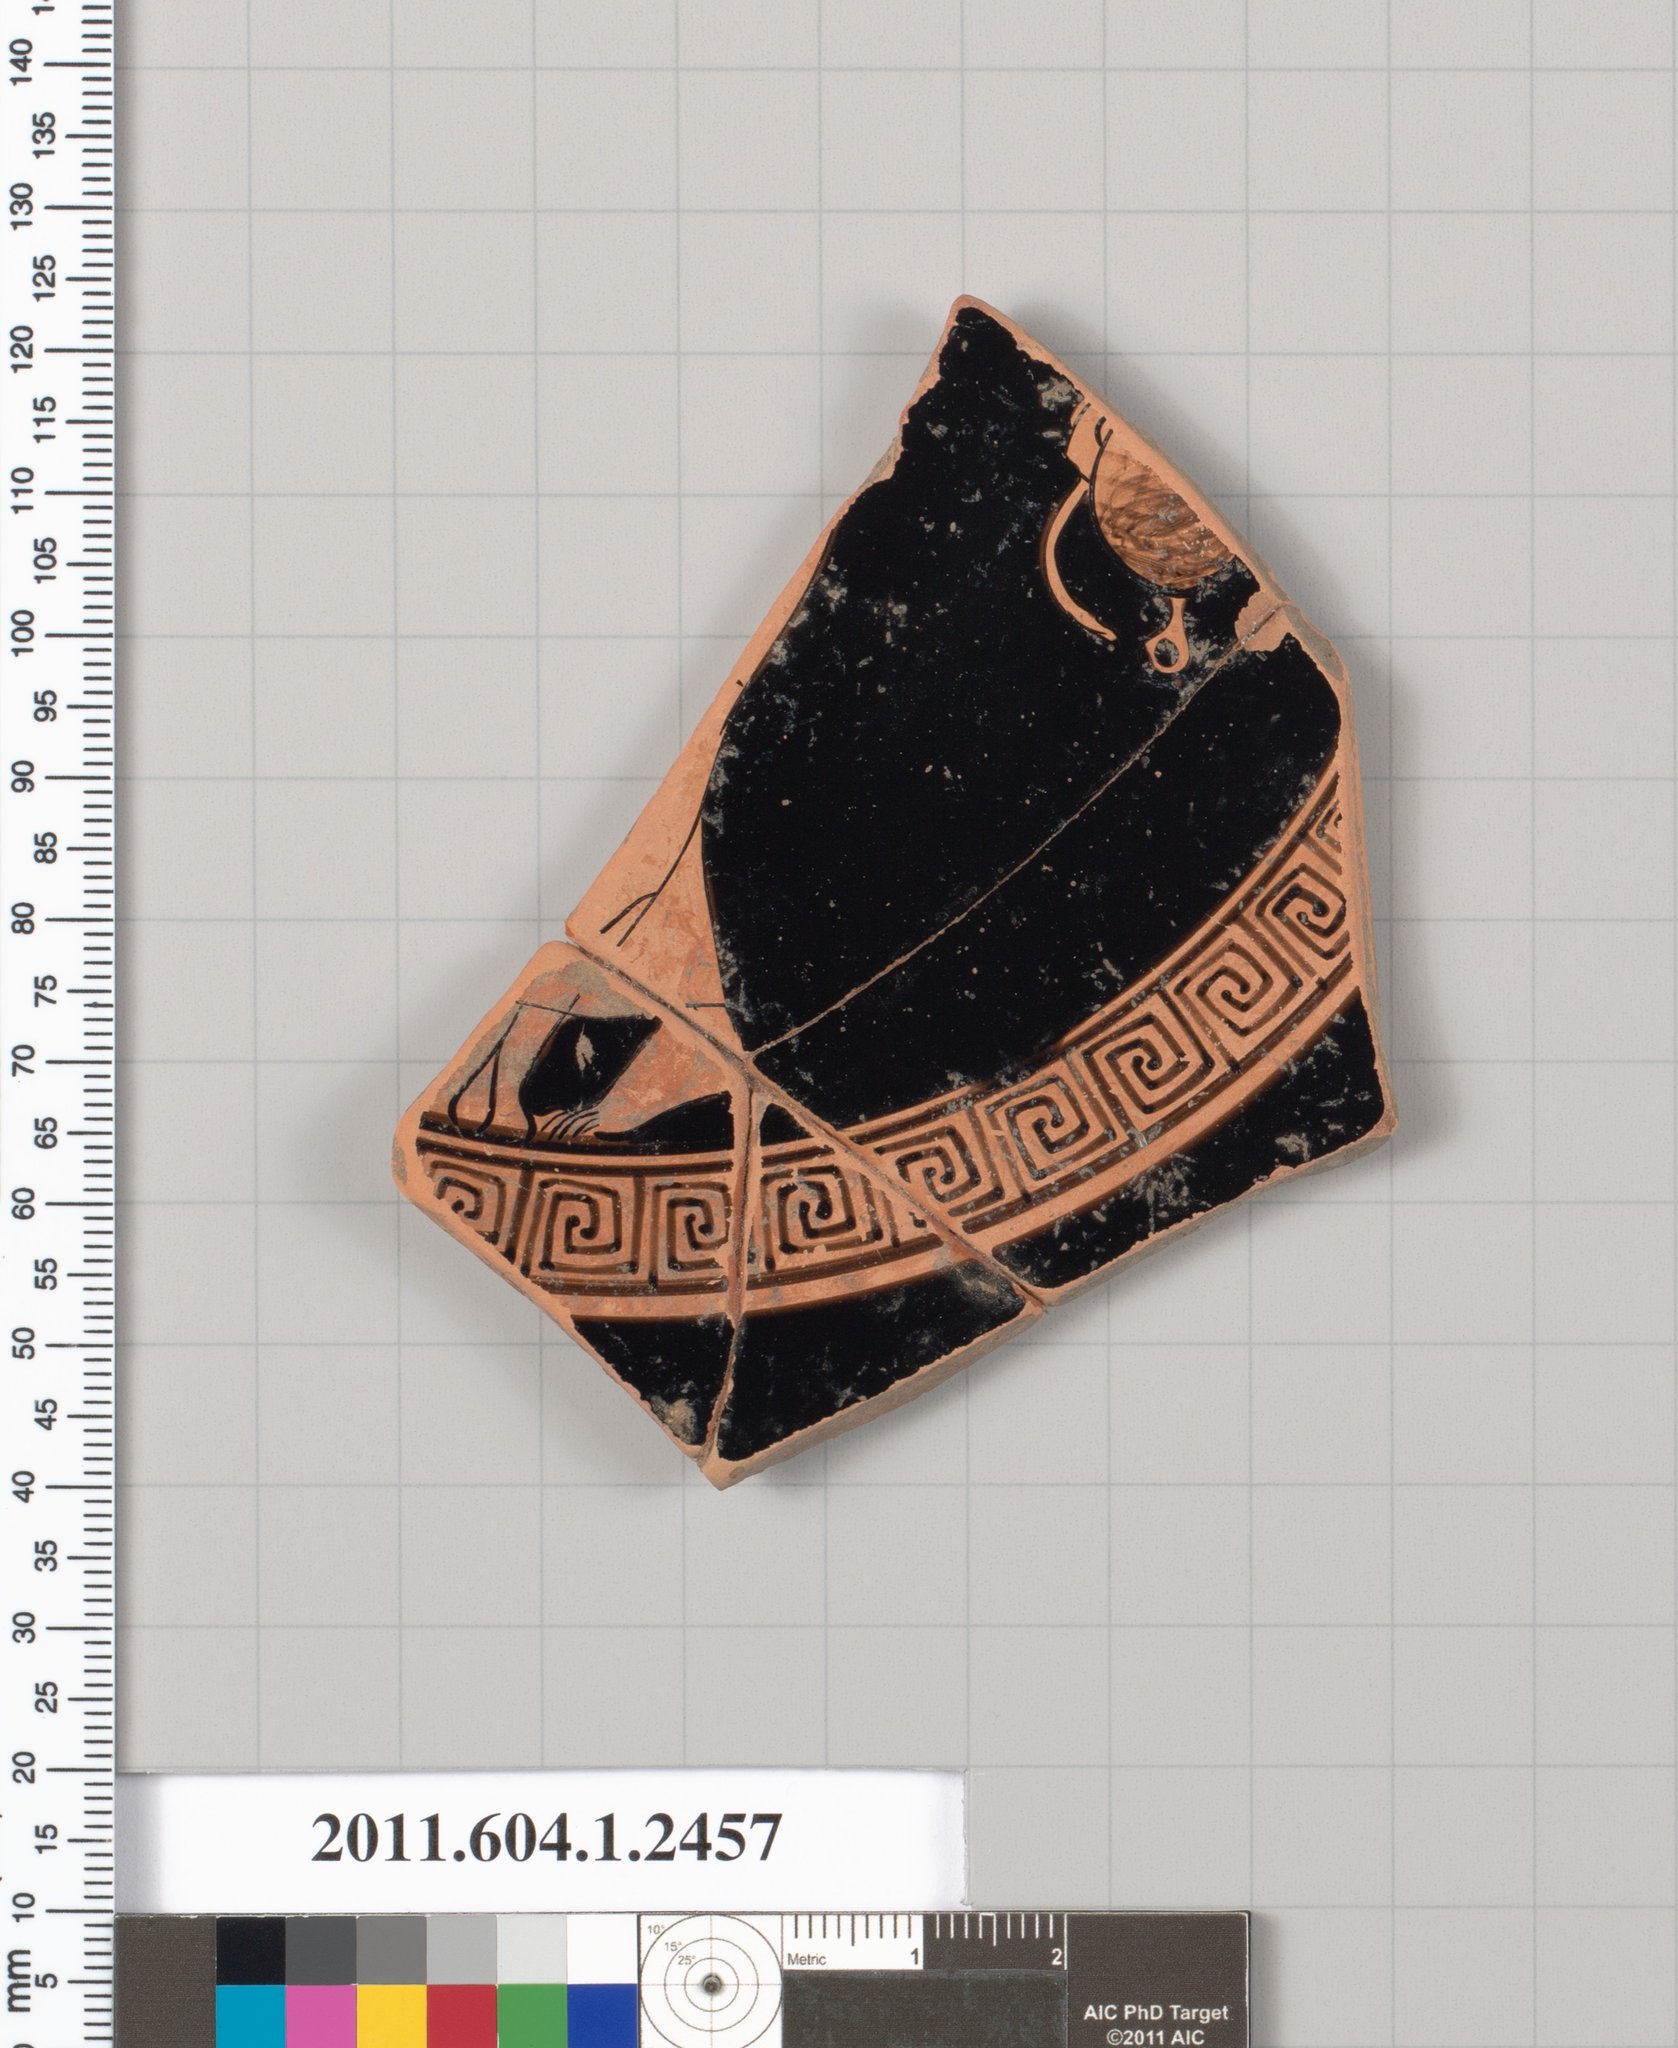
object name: kylix fragment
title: Terracotta fragment of a kylix (drinking cup)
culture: greek, attic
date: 490-480 BCE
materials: terracotta